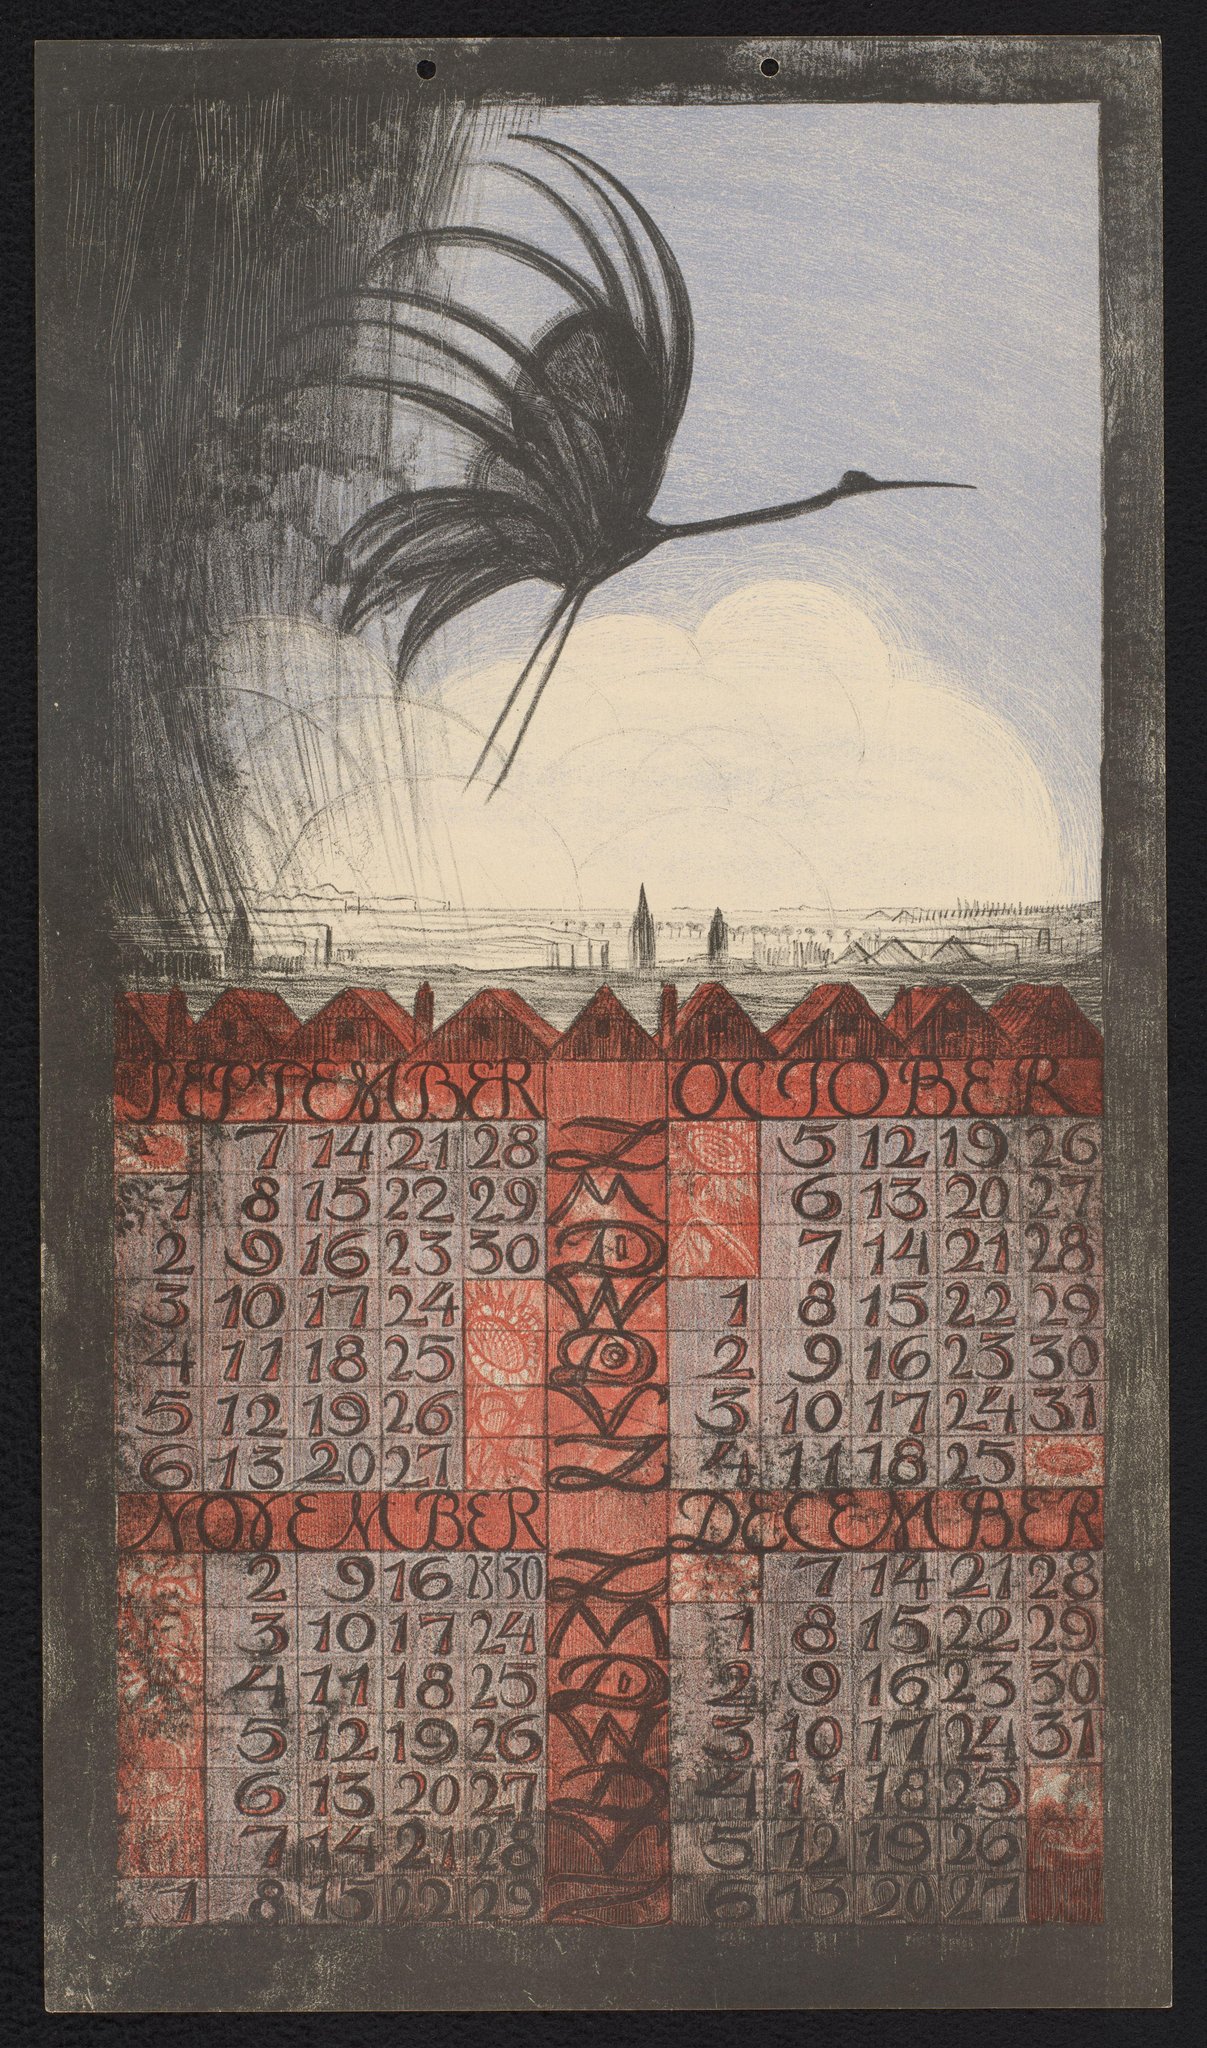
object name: calendar leaf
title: Kalenderblad voor september tot en met december 1924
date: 1923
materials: paper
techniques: lithograph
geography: amsterdam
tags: roof (of house or building), birds, church (exterior), landscape with tower or castle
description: Een overvliegende vogel met daaronder een landschap met daken, kerktorens en rokende schoorstenen.